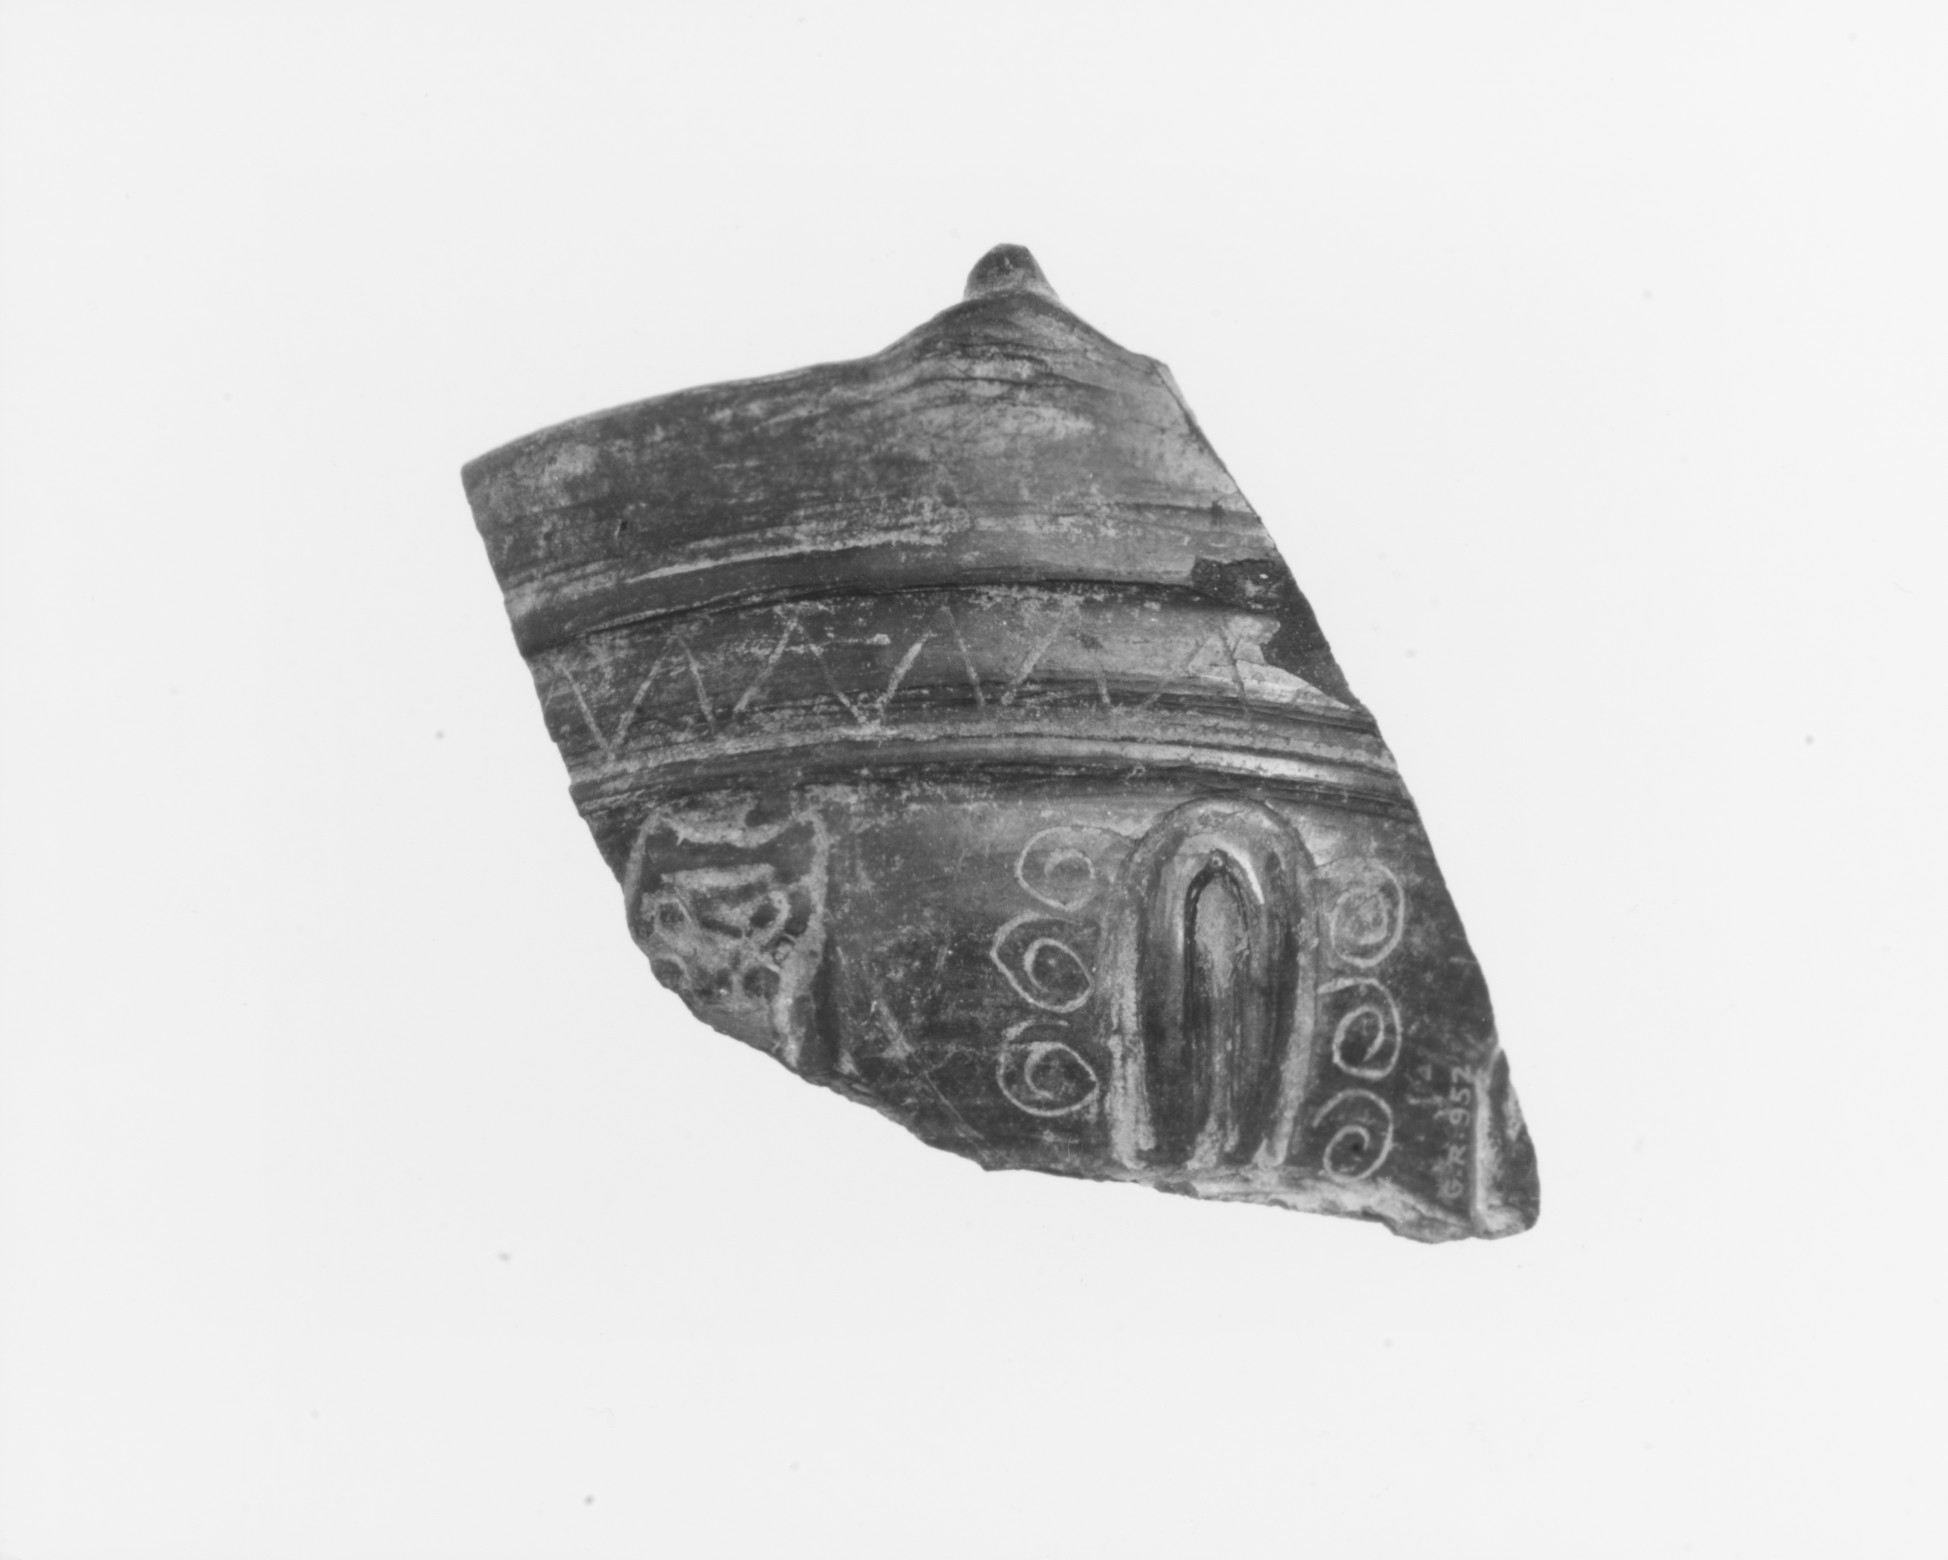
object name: vase fragment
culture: etruscan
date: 550-501 BCE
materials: terracotta